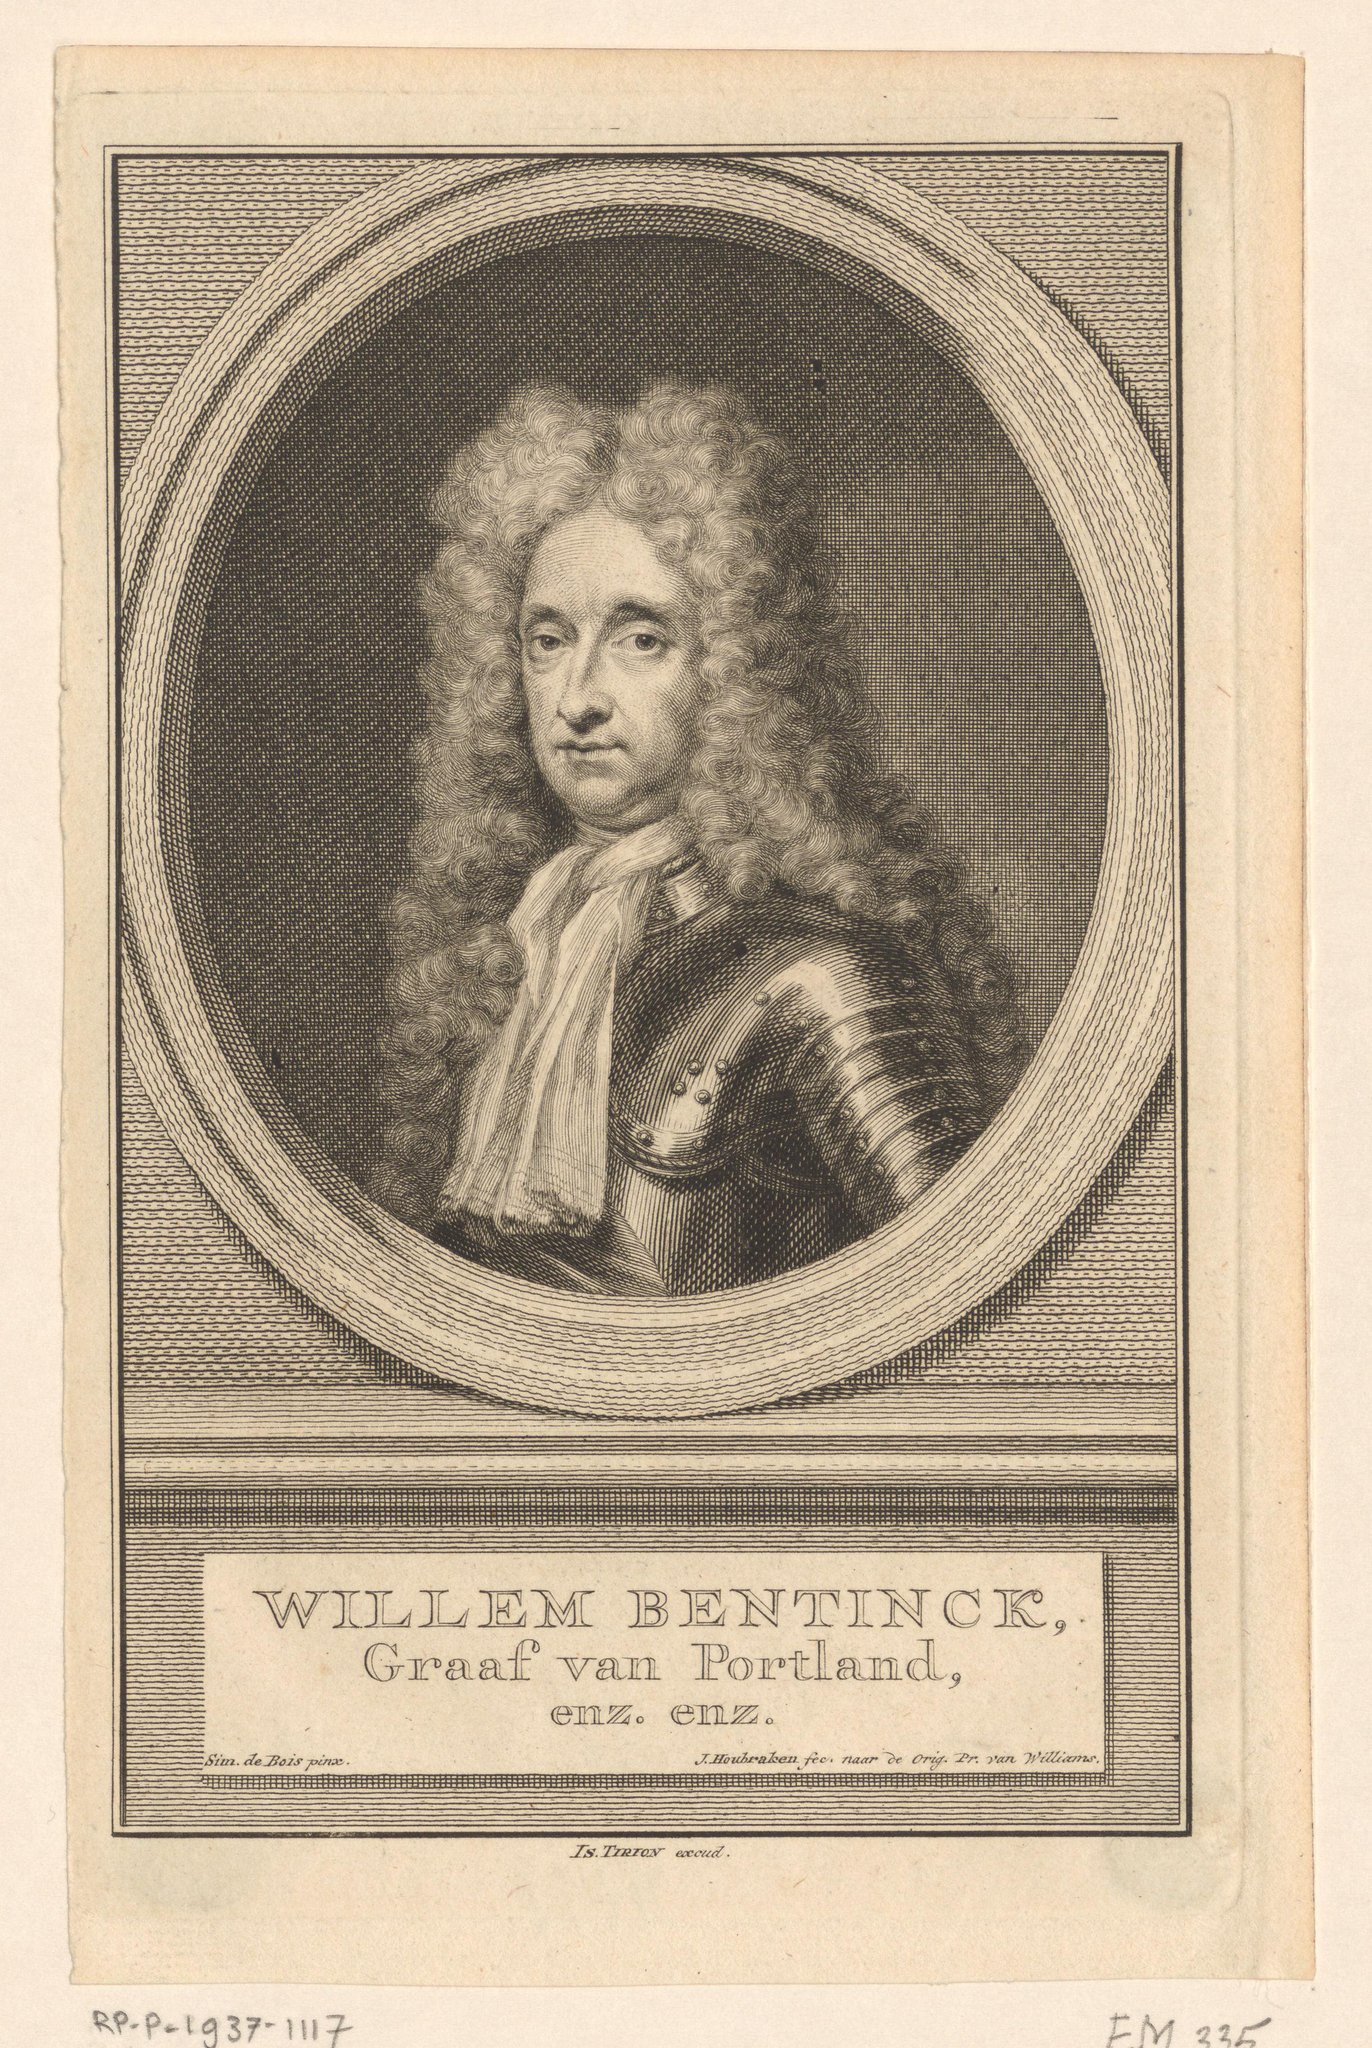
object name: book illustration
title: Portret van Hans Willem Bentinck, graaf van Portland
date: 1749-1759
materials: paper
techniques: engraving, etching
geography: amsterdam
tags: armour, historical persons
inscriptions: collector's mark: Lugt 2228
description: Prent uit: Wagenaar, Jan. Vaderlandsche historie, vervattende de geschiedenissen der nu Vereenigde Nederlanden (...). 21 dln. Amsterdam: Isaak Tirion, 1749-1759.